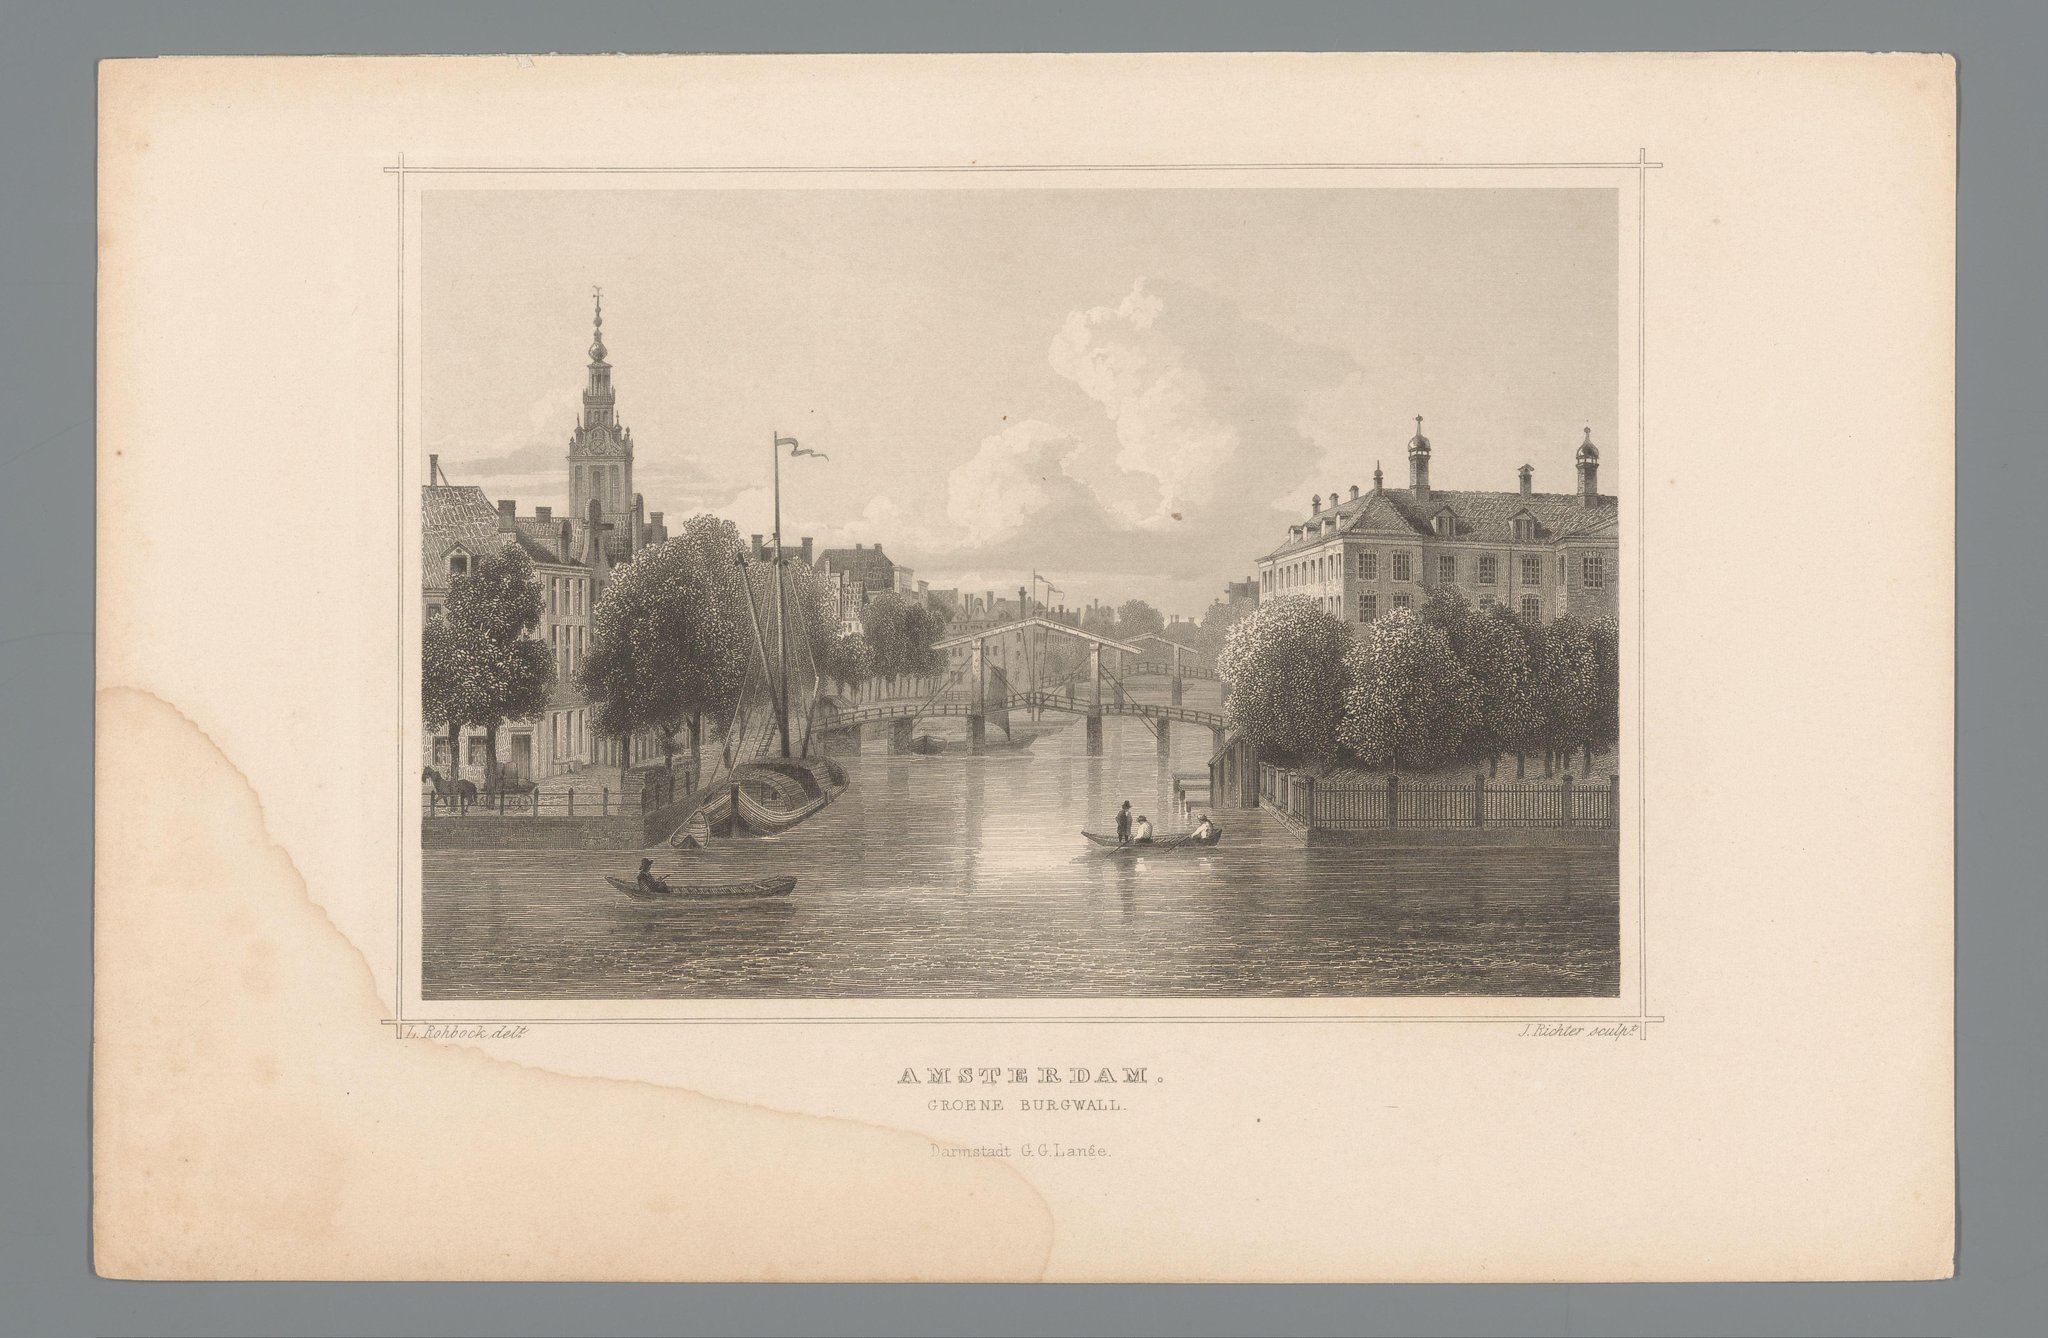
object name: print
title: Amsterdam, Groene Burgwall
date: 1800-1875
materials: paper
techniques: lithograph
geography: darmstadt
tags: city-view, and landscape with man-made constructions, canals, waters (in city), amsterdam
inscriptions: collector's mark: Lugt 2233